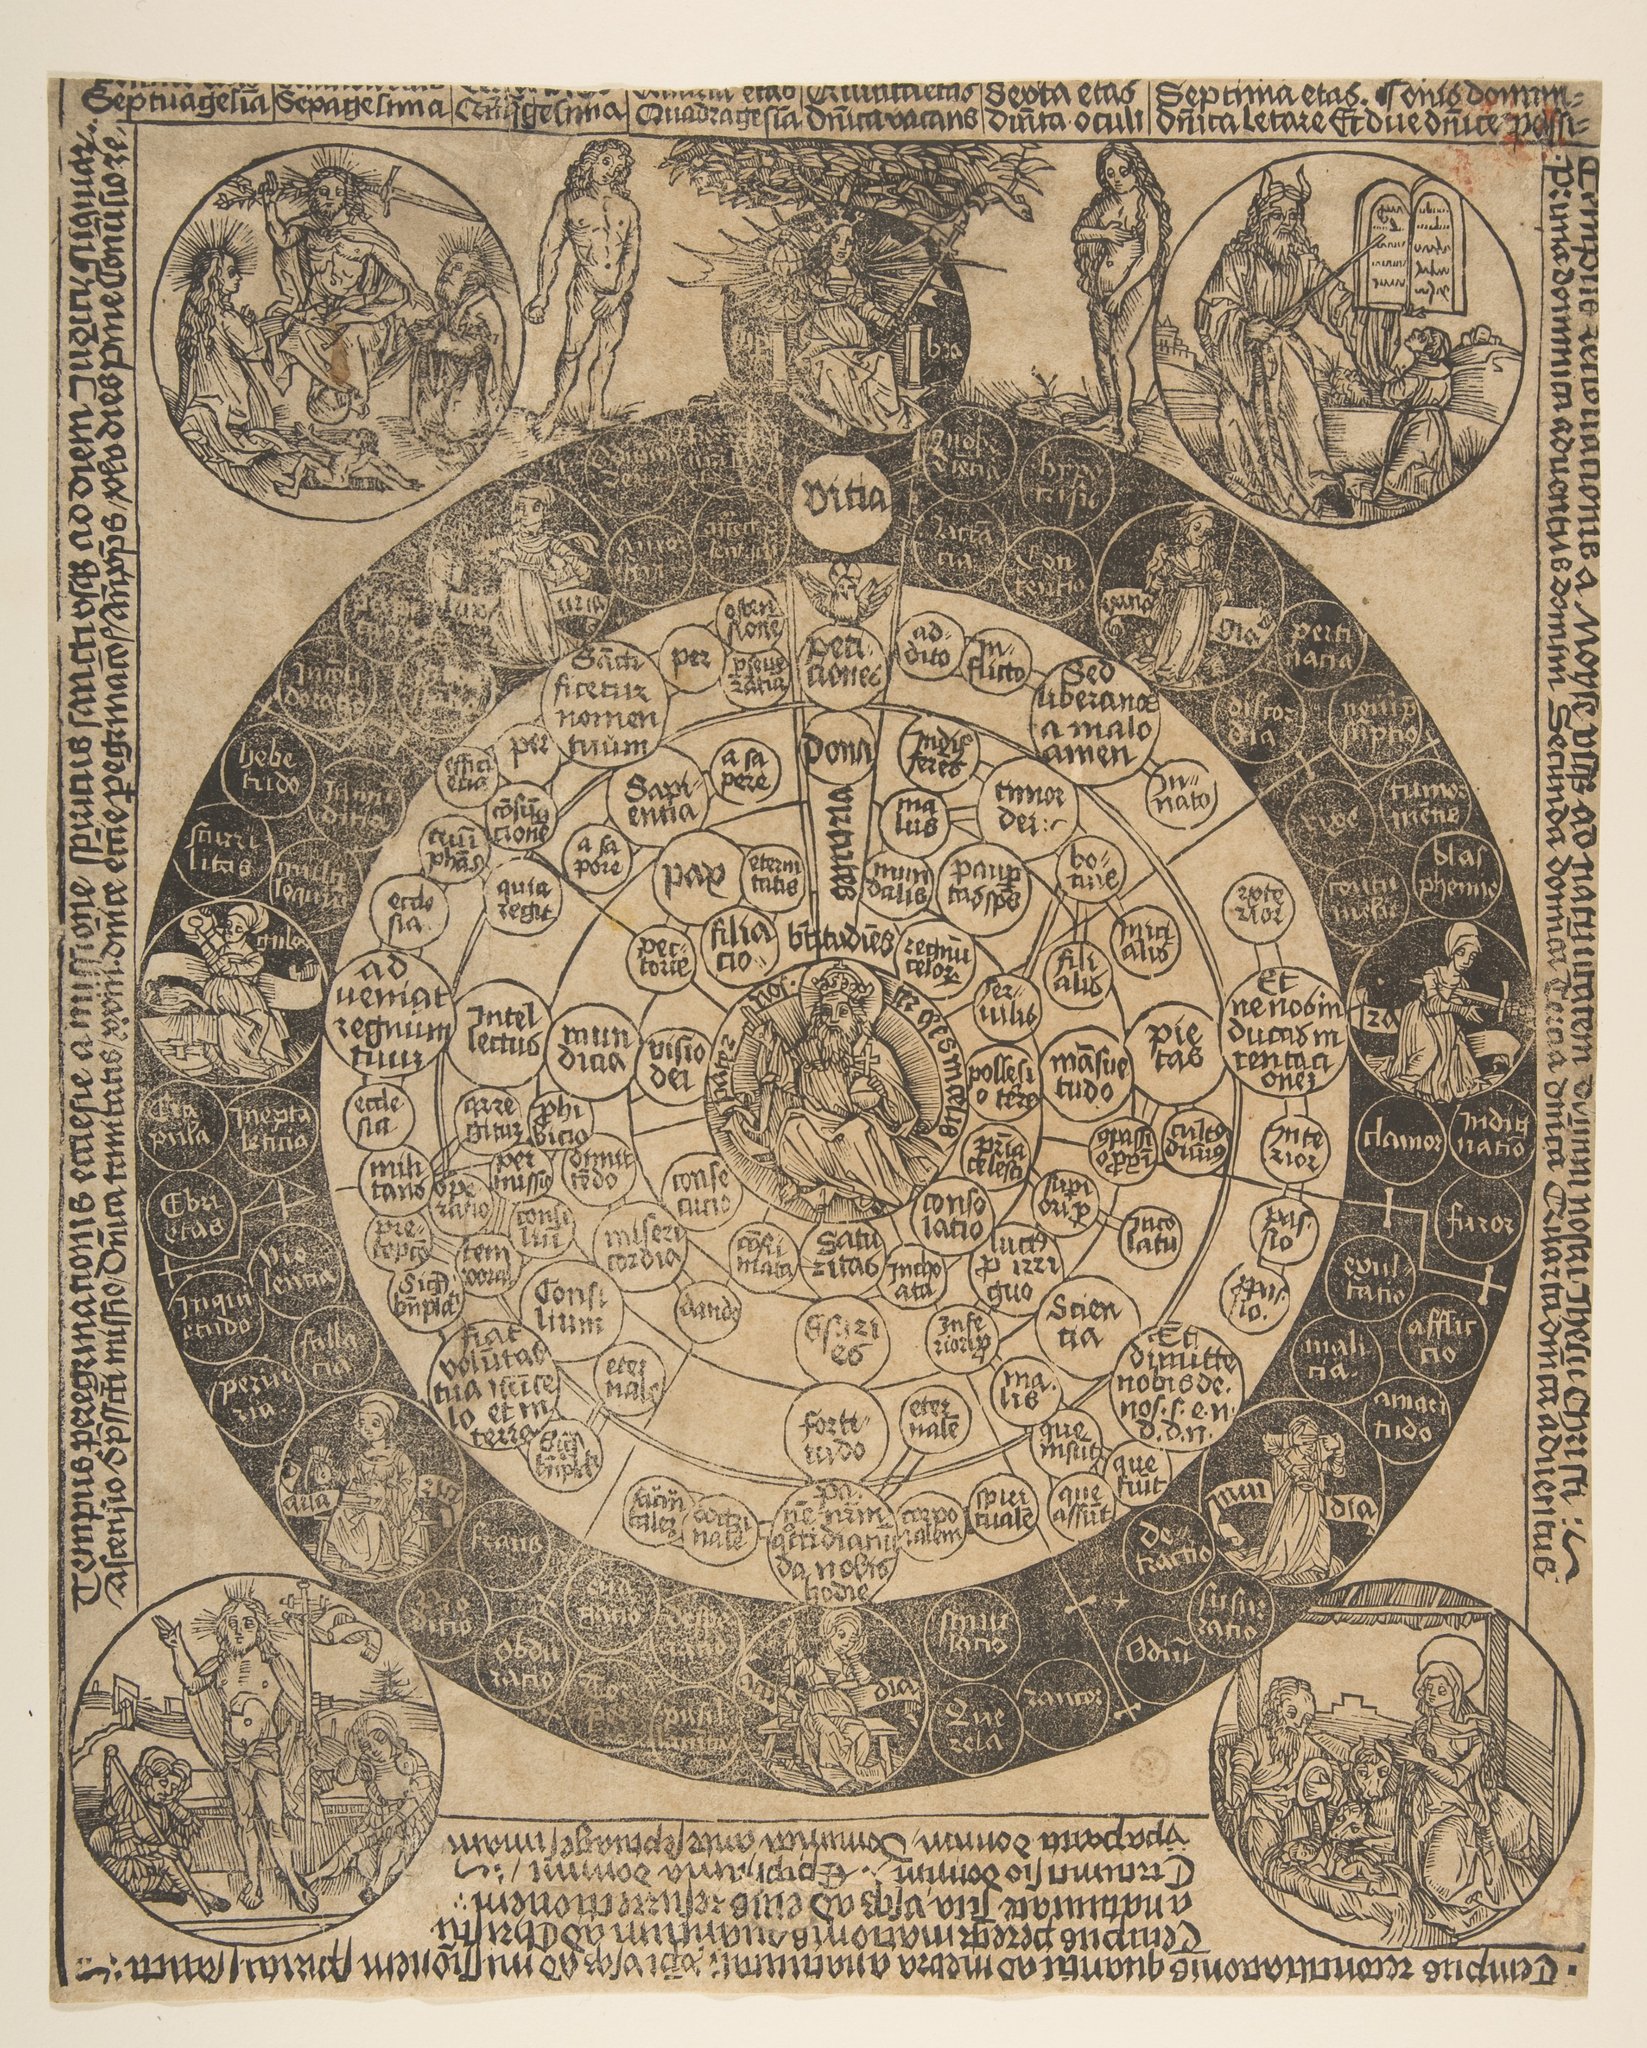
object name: print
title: The Lord's Prayer and the Four Ages of the World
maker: anonymous, german, 15th century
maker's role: artist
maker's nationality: german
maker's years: 1400-1500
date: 1401-1500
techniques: woodcut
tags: men,women,christ,nativity